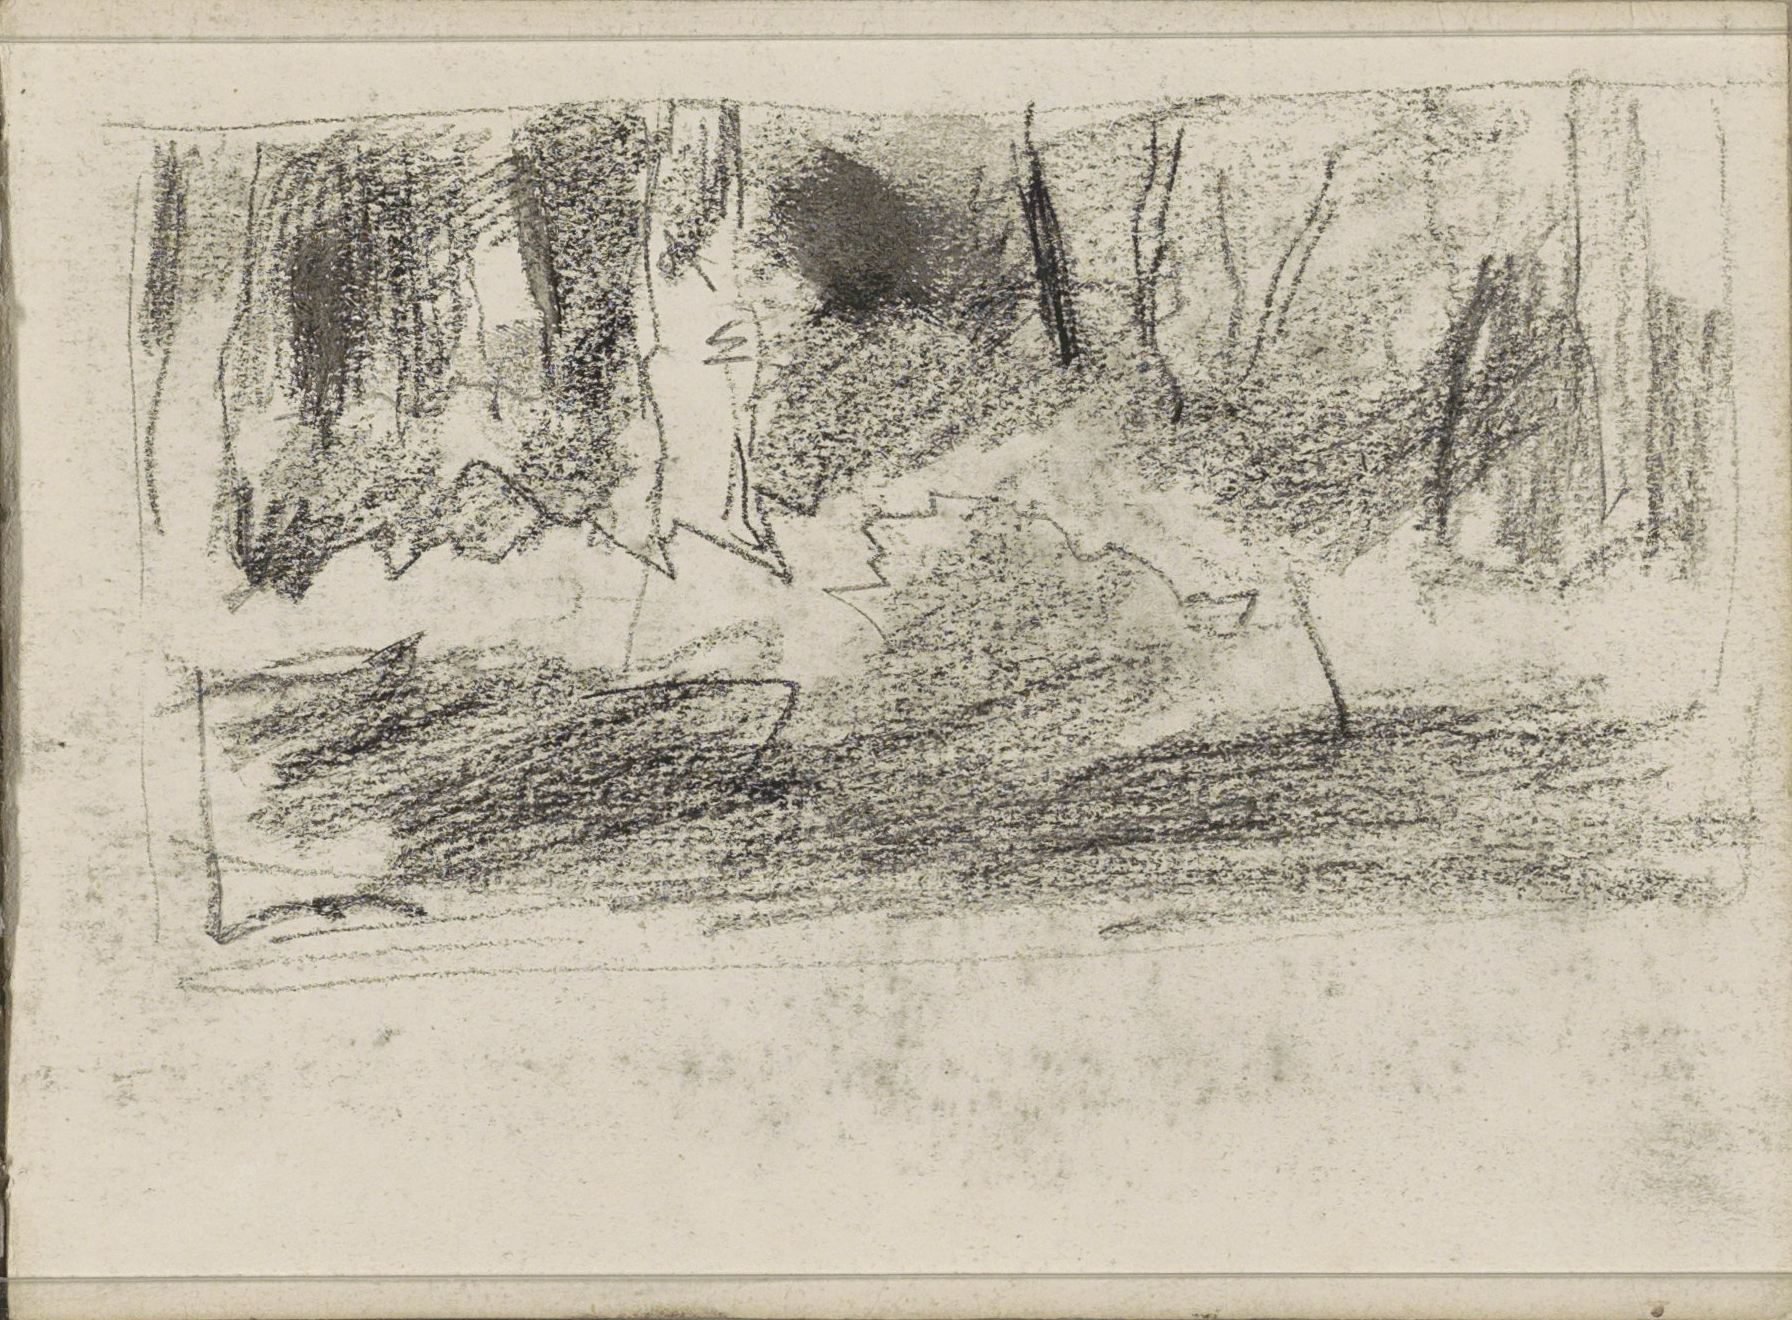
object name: sketchbook leaf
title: Bosgrond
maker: anton mauve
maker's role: draughtsman, painter, print maker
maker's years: 1838-1888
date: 1848-1888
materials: chalk, paper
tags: forest, wood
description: Blad 12 recto uit een schetsboek met 33 bladen.